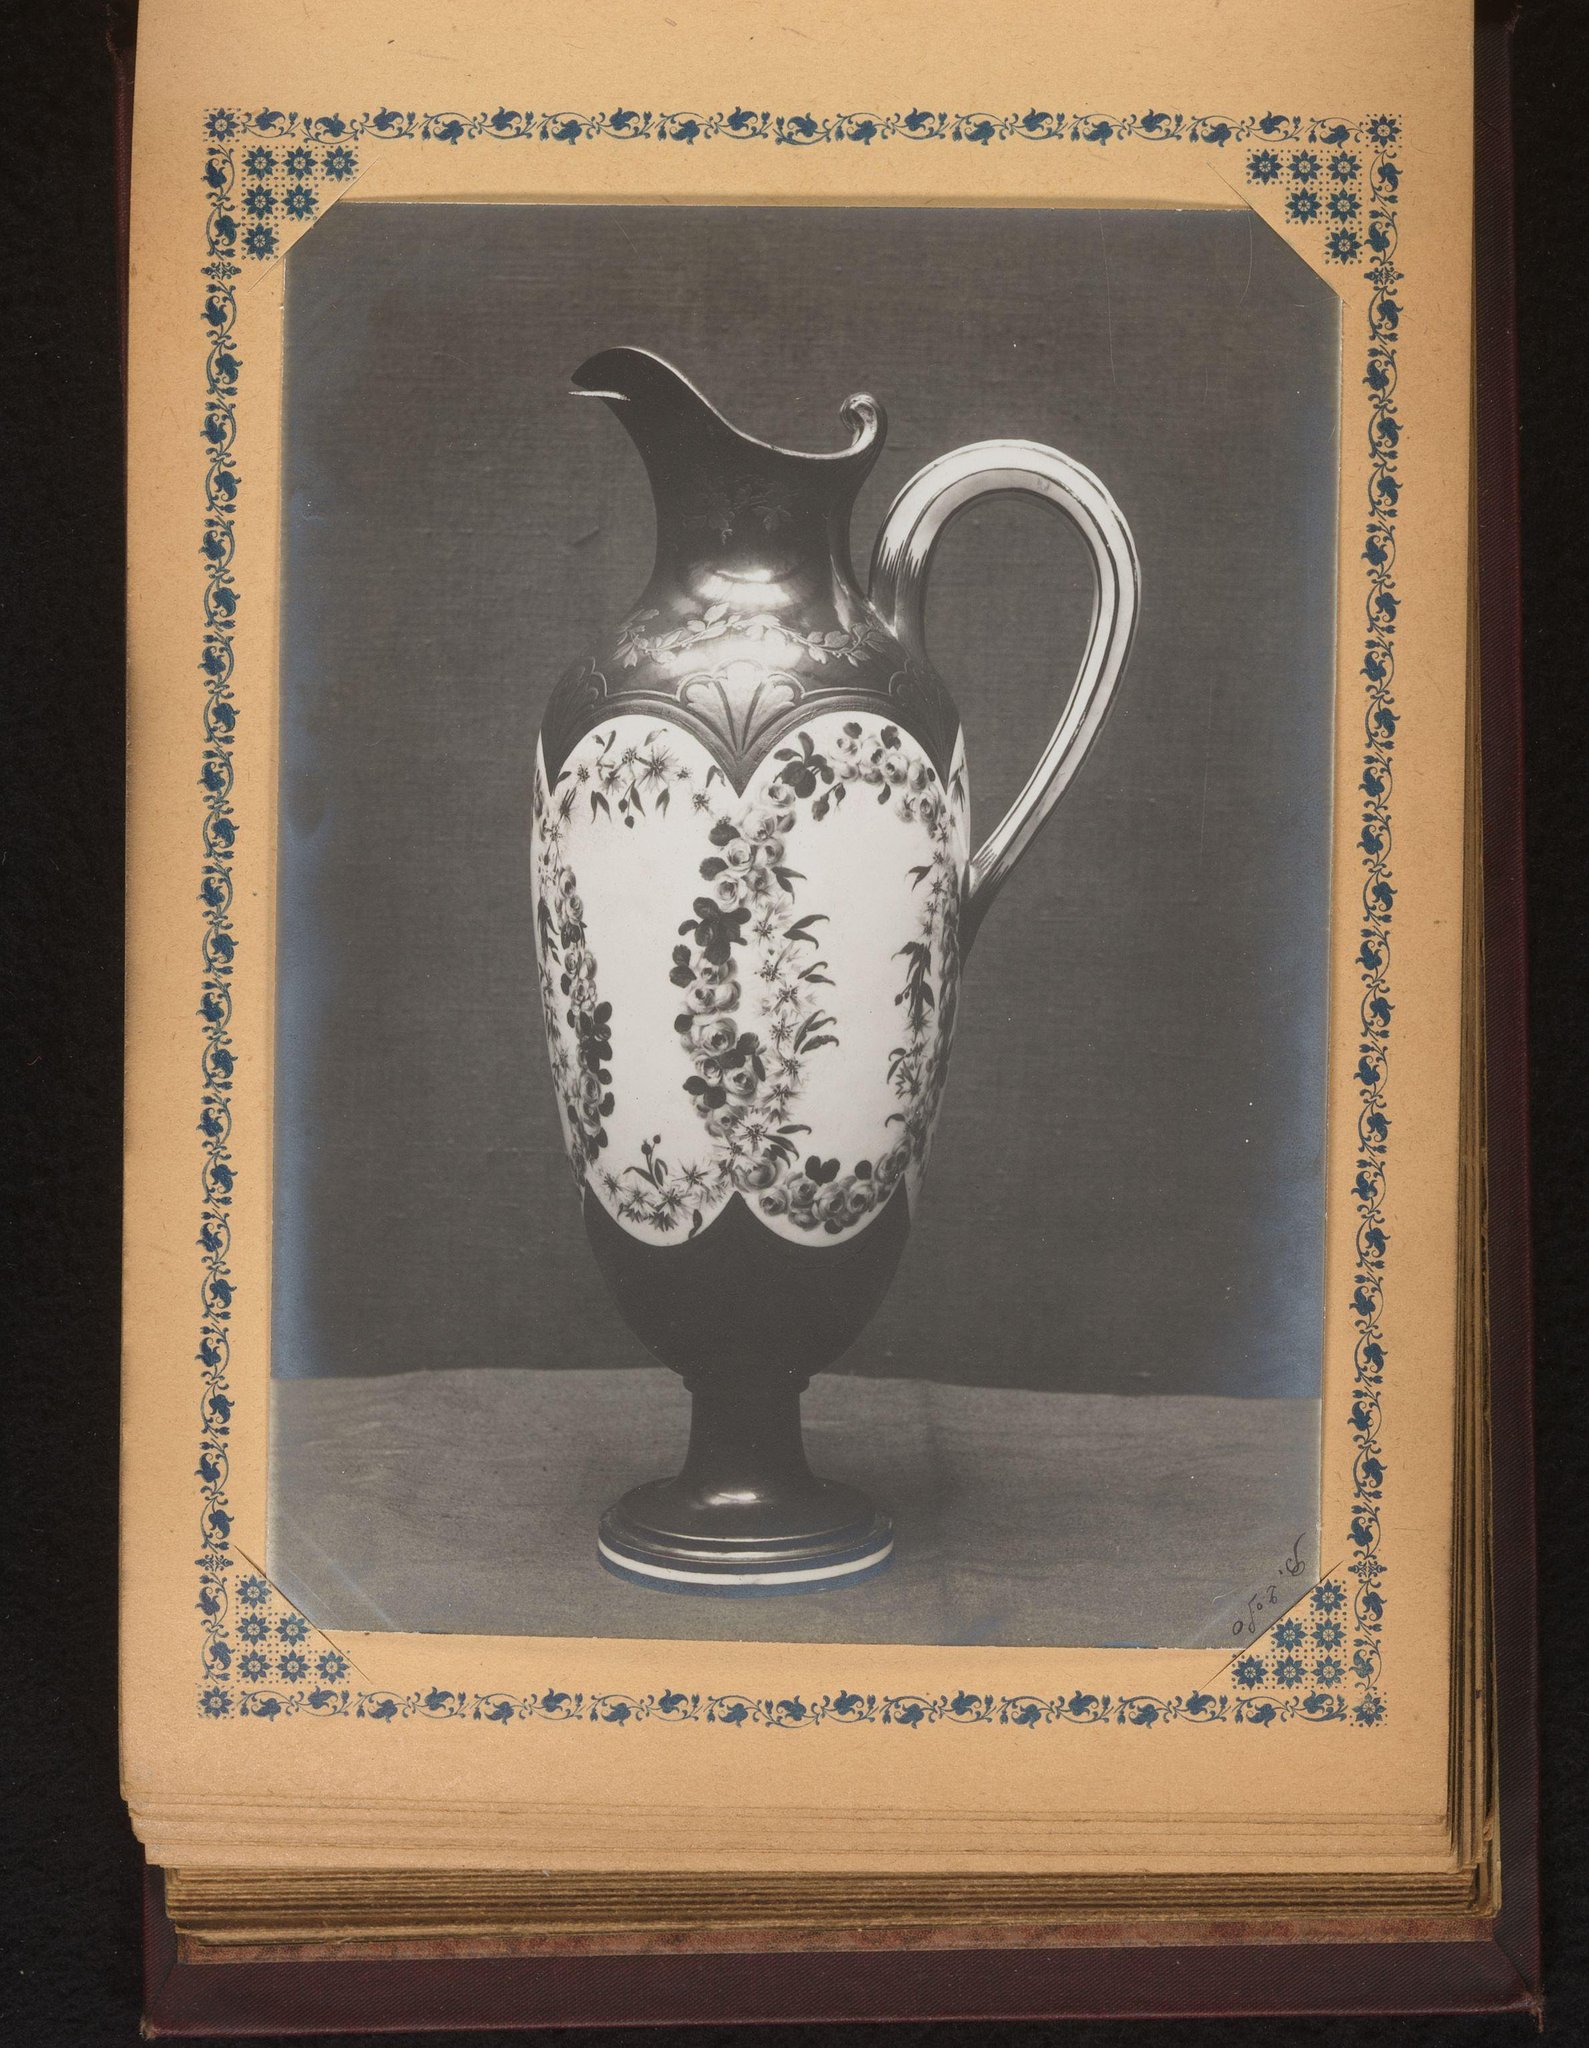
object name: photograph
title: Kan beschilderd met bloemen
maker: Anonymous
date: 1880-1940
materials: cardboard, photographic support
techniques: gelatin silver print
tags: flowers, container of ceramics: jar, jug, pot, vase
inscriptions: number: ‘B. 2[0] 9 [0]’